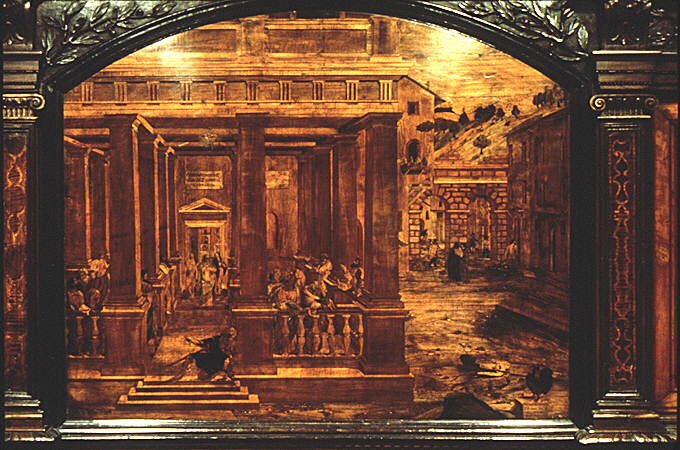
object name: panel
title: The Descent of the Holy Spirit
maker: francesco orlandini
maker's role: maker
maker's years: 1500-1600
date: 1547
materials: wood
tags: buildings